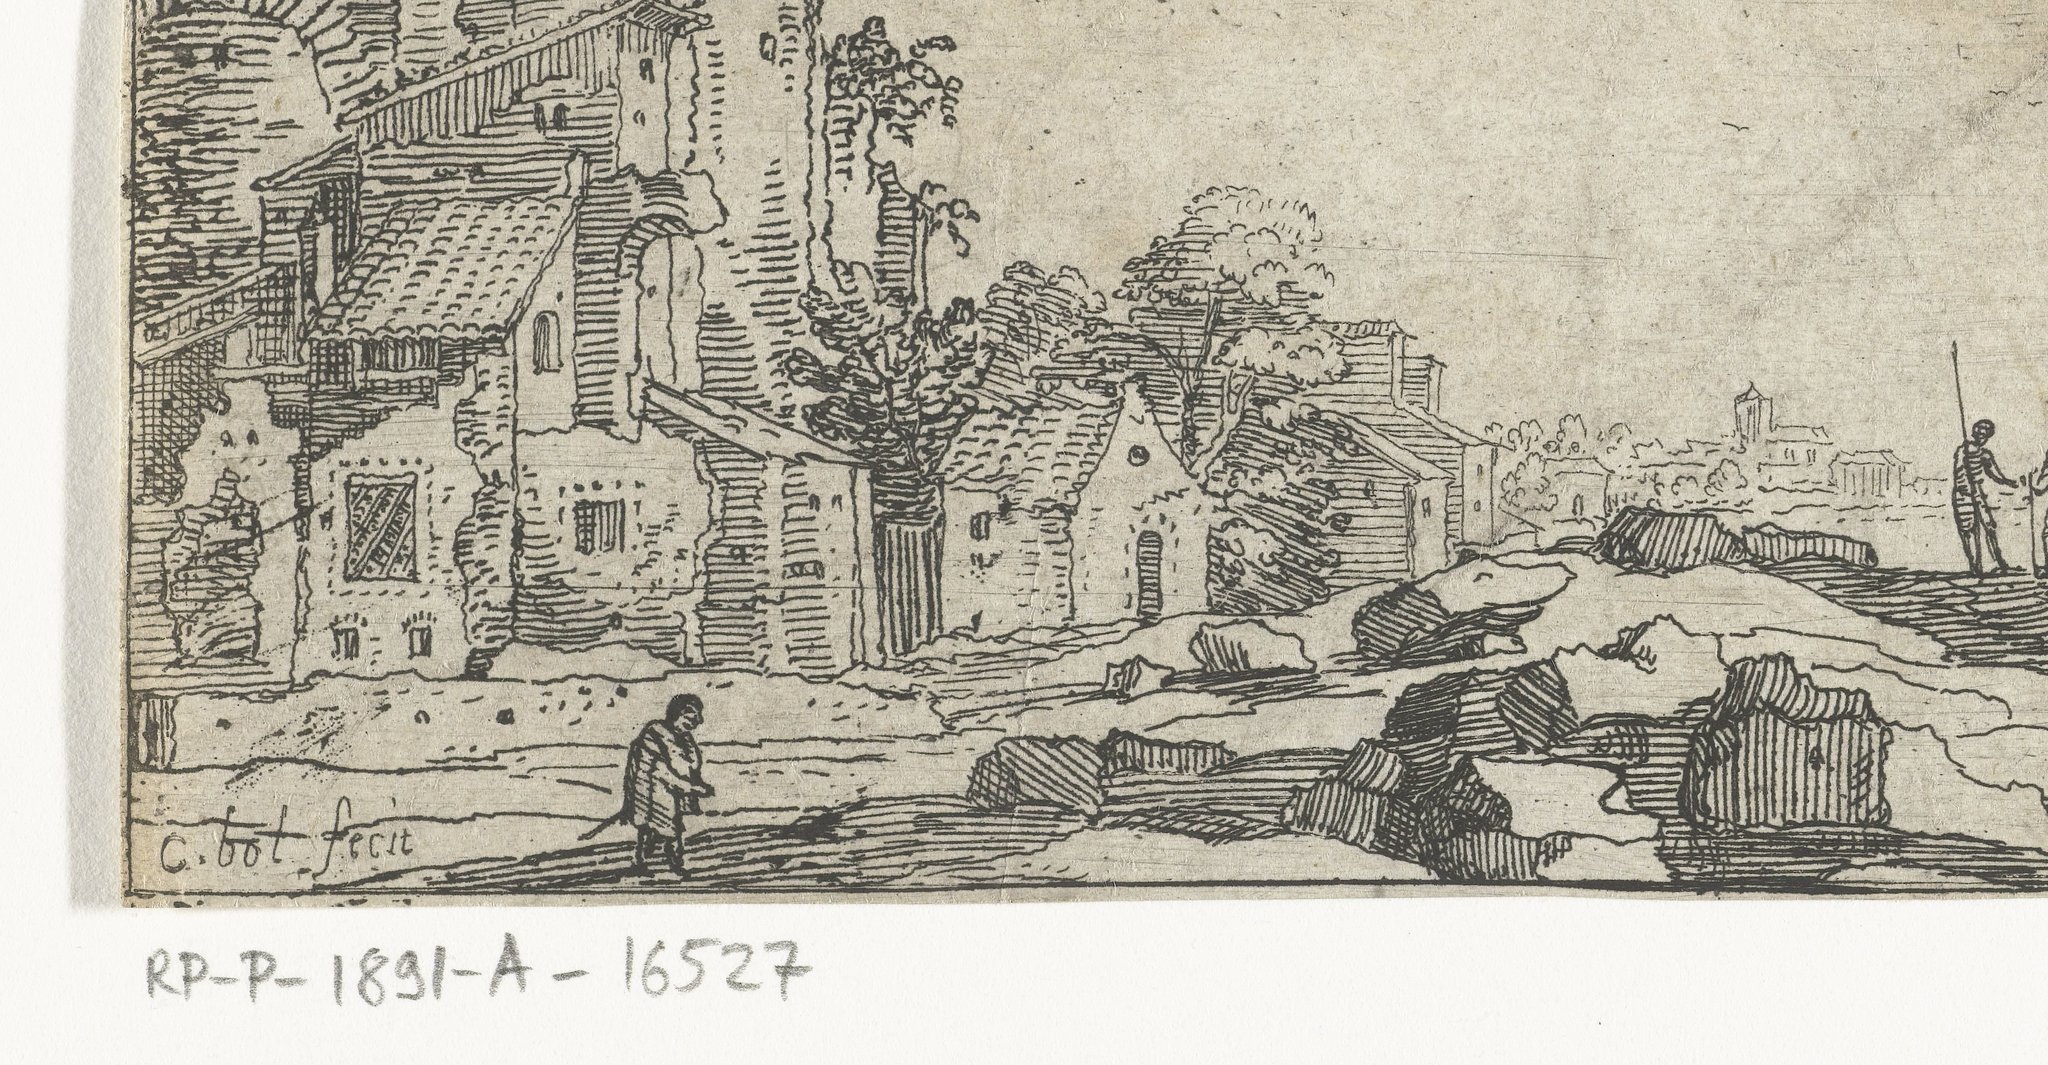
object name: print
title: Landschappen en marines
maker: cornelis bol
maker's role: print maker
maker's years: 1589-1666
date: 1615-1666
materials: paper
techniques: etching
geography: netherlands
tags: city-view, and landscape with man-made constructions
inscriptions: collector's mark: Lugt 2228